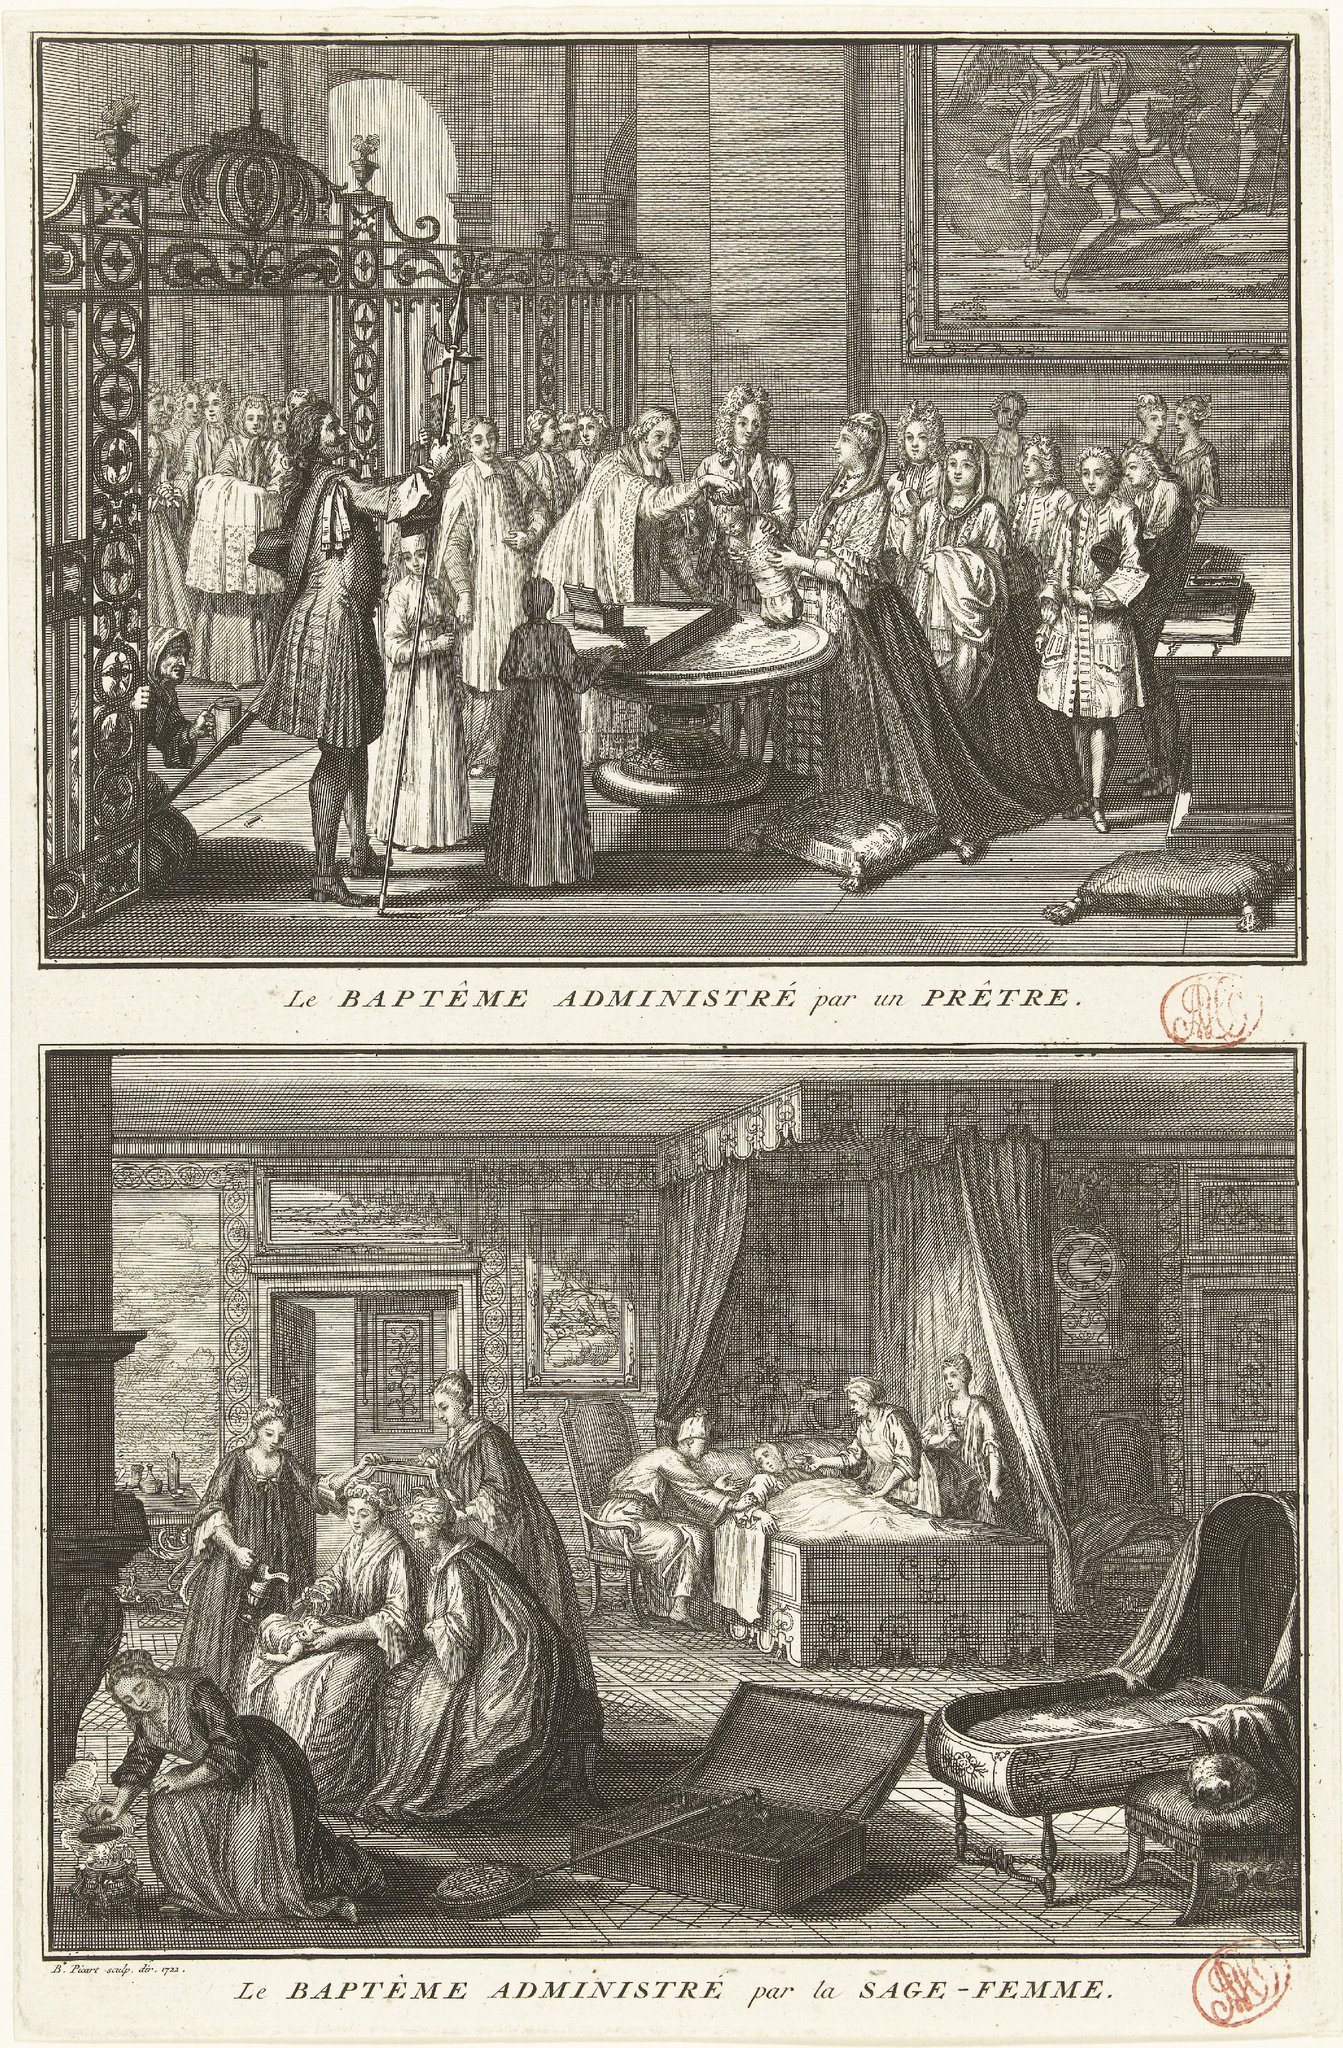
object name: print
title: Le Baptême Administré par un Prêtre / Le Baptême Administré par la Sage-Femme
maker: bernard picart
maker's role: draughtsman, print maker, publisher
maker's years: 1673-1733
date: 1722-1727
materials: paper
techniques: engraving, etching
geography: amsterdam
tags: nursing-chair (dutch: 'bakermat'), baptism, christening ceremony ~ the first of the seven sacraments, midwife, 'accoucheuse'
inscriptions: collector's mark: Lugt 195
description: Prent ook gebruikt in: Picart, Bernard. Ceremonies et coutumes religieuses de tous les peuples du monde (...). 10 delen. Amsterdam: Jean Frederic Bernard, 1723-1743, dl. 2 (1723), na p. 66. En in de Nederlandse vertaling: Picart, Bernard en Abraham Moubach. Naaukeurige beschryving der uitwendige godtsdienst-plichten, kerk-zeden en gewoontens van alle volkeren der waereldt : in een historisch verhaal (...). 6 delen. 's-Gravenhage: Rutgert Christoffel Alberts, 1727-1738, dl. 2 (1727), na p. 64. En waarschijnlijk ook in de Engelse vertaling. Niet in Frederik Muller; door het RPK toegevoegd nummer.